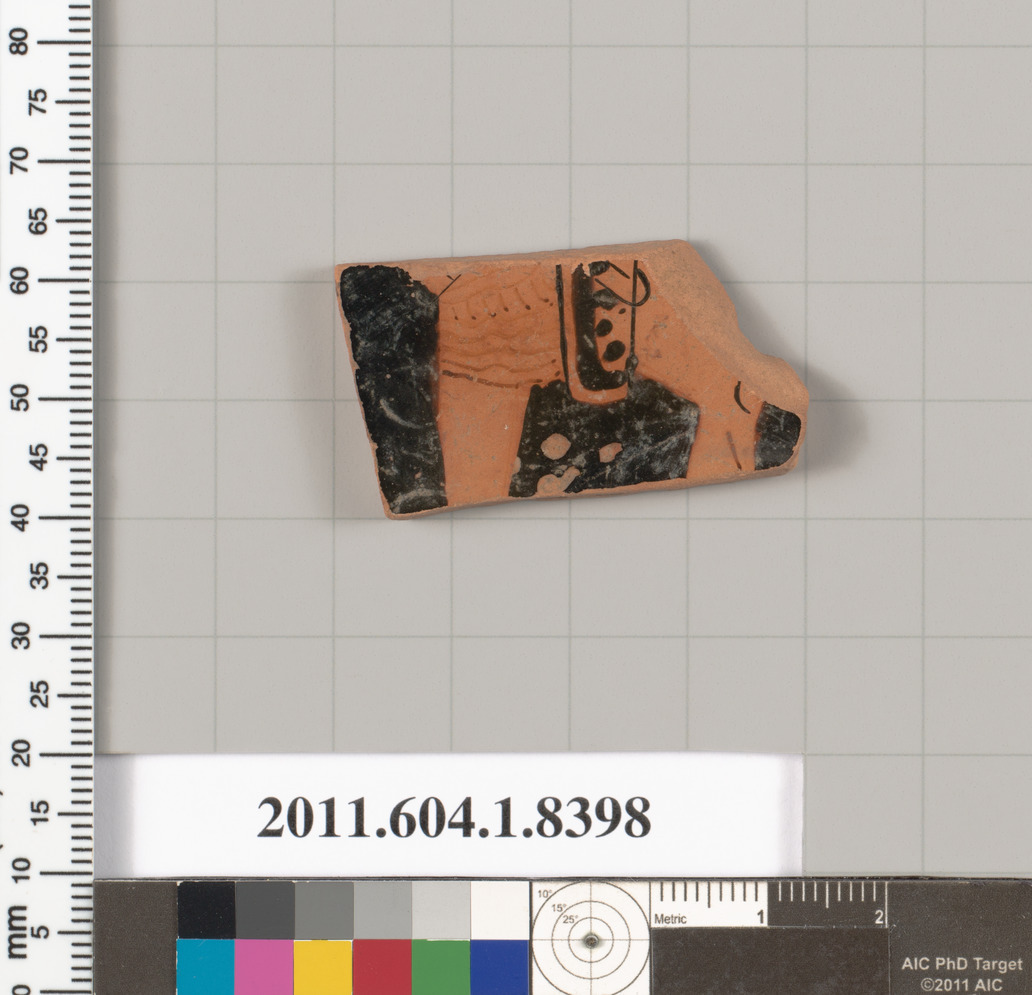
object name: kylix fragment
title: Terracotta fragment of a kylix (drinking cup)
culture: greek, attic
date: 434-368 BCE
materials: terracotta